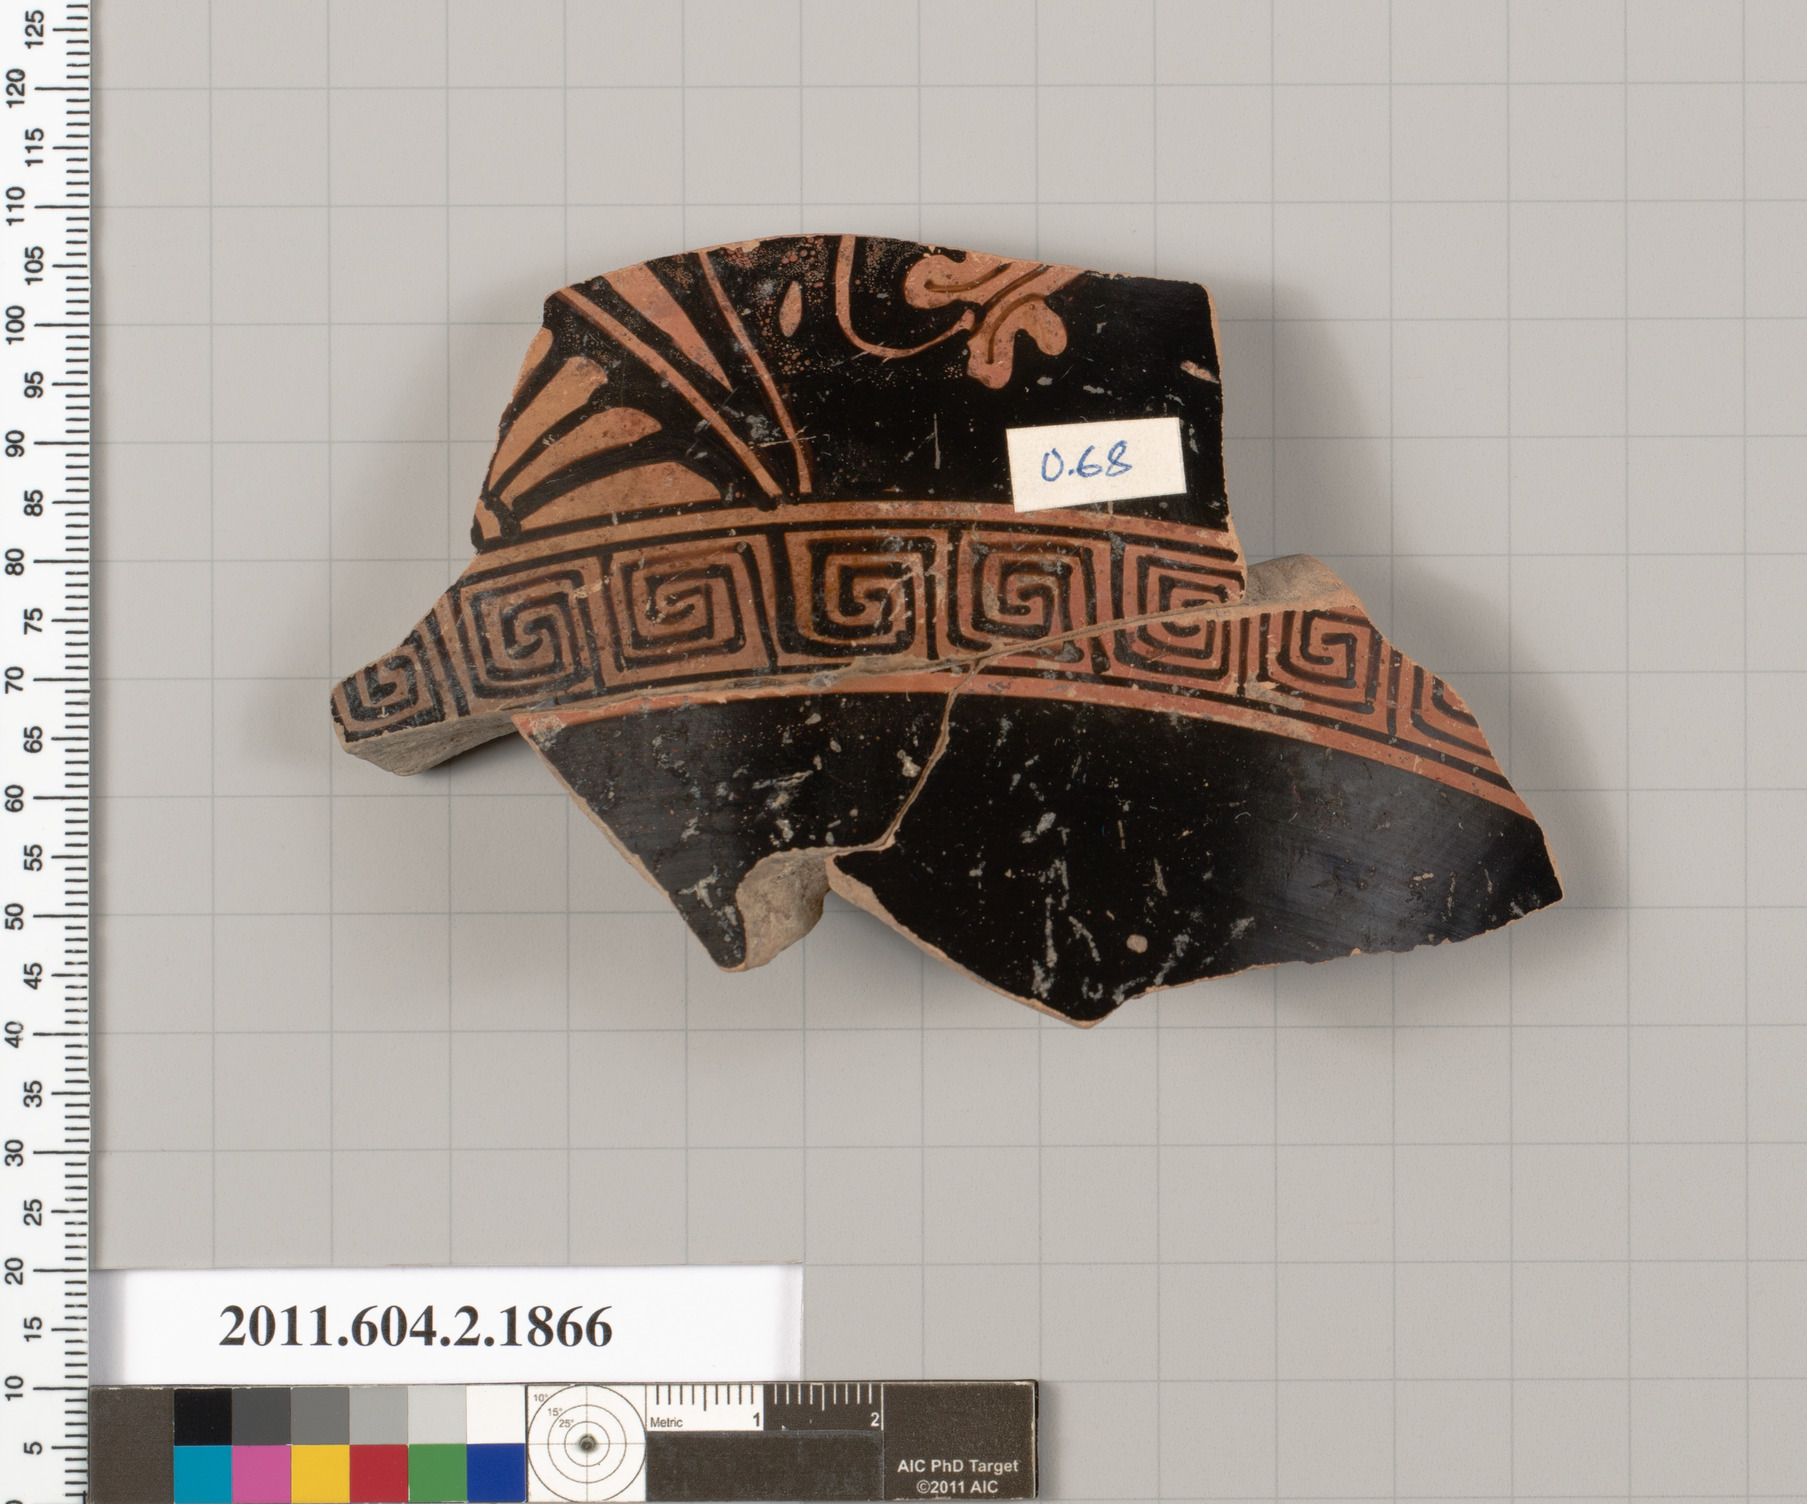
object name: skyphos fragment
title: Terracotta fragment of a skyphos (deep drinking cup)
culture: greek, attic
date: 460-450 BCE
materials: terracotta